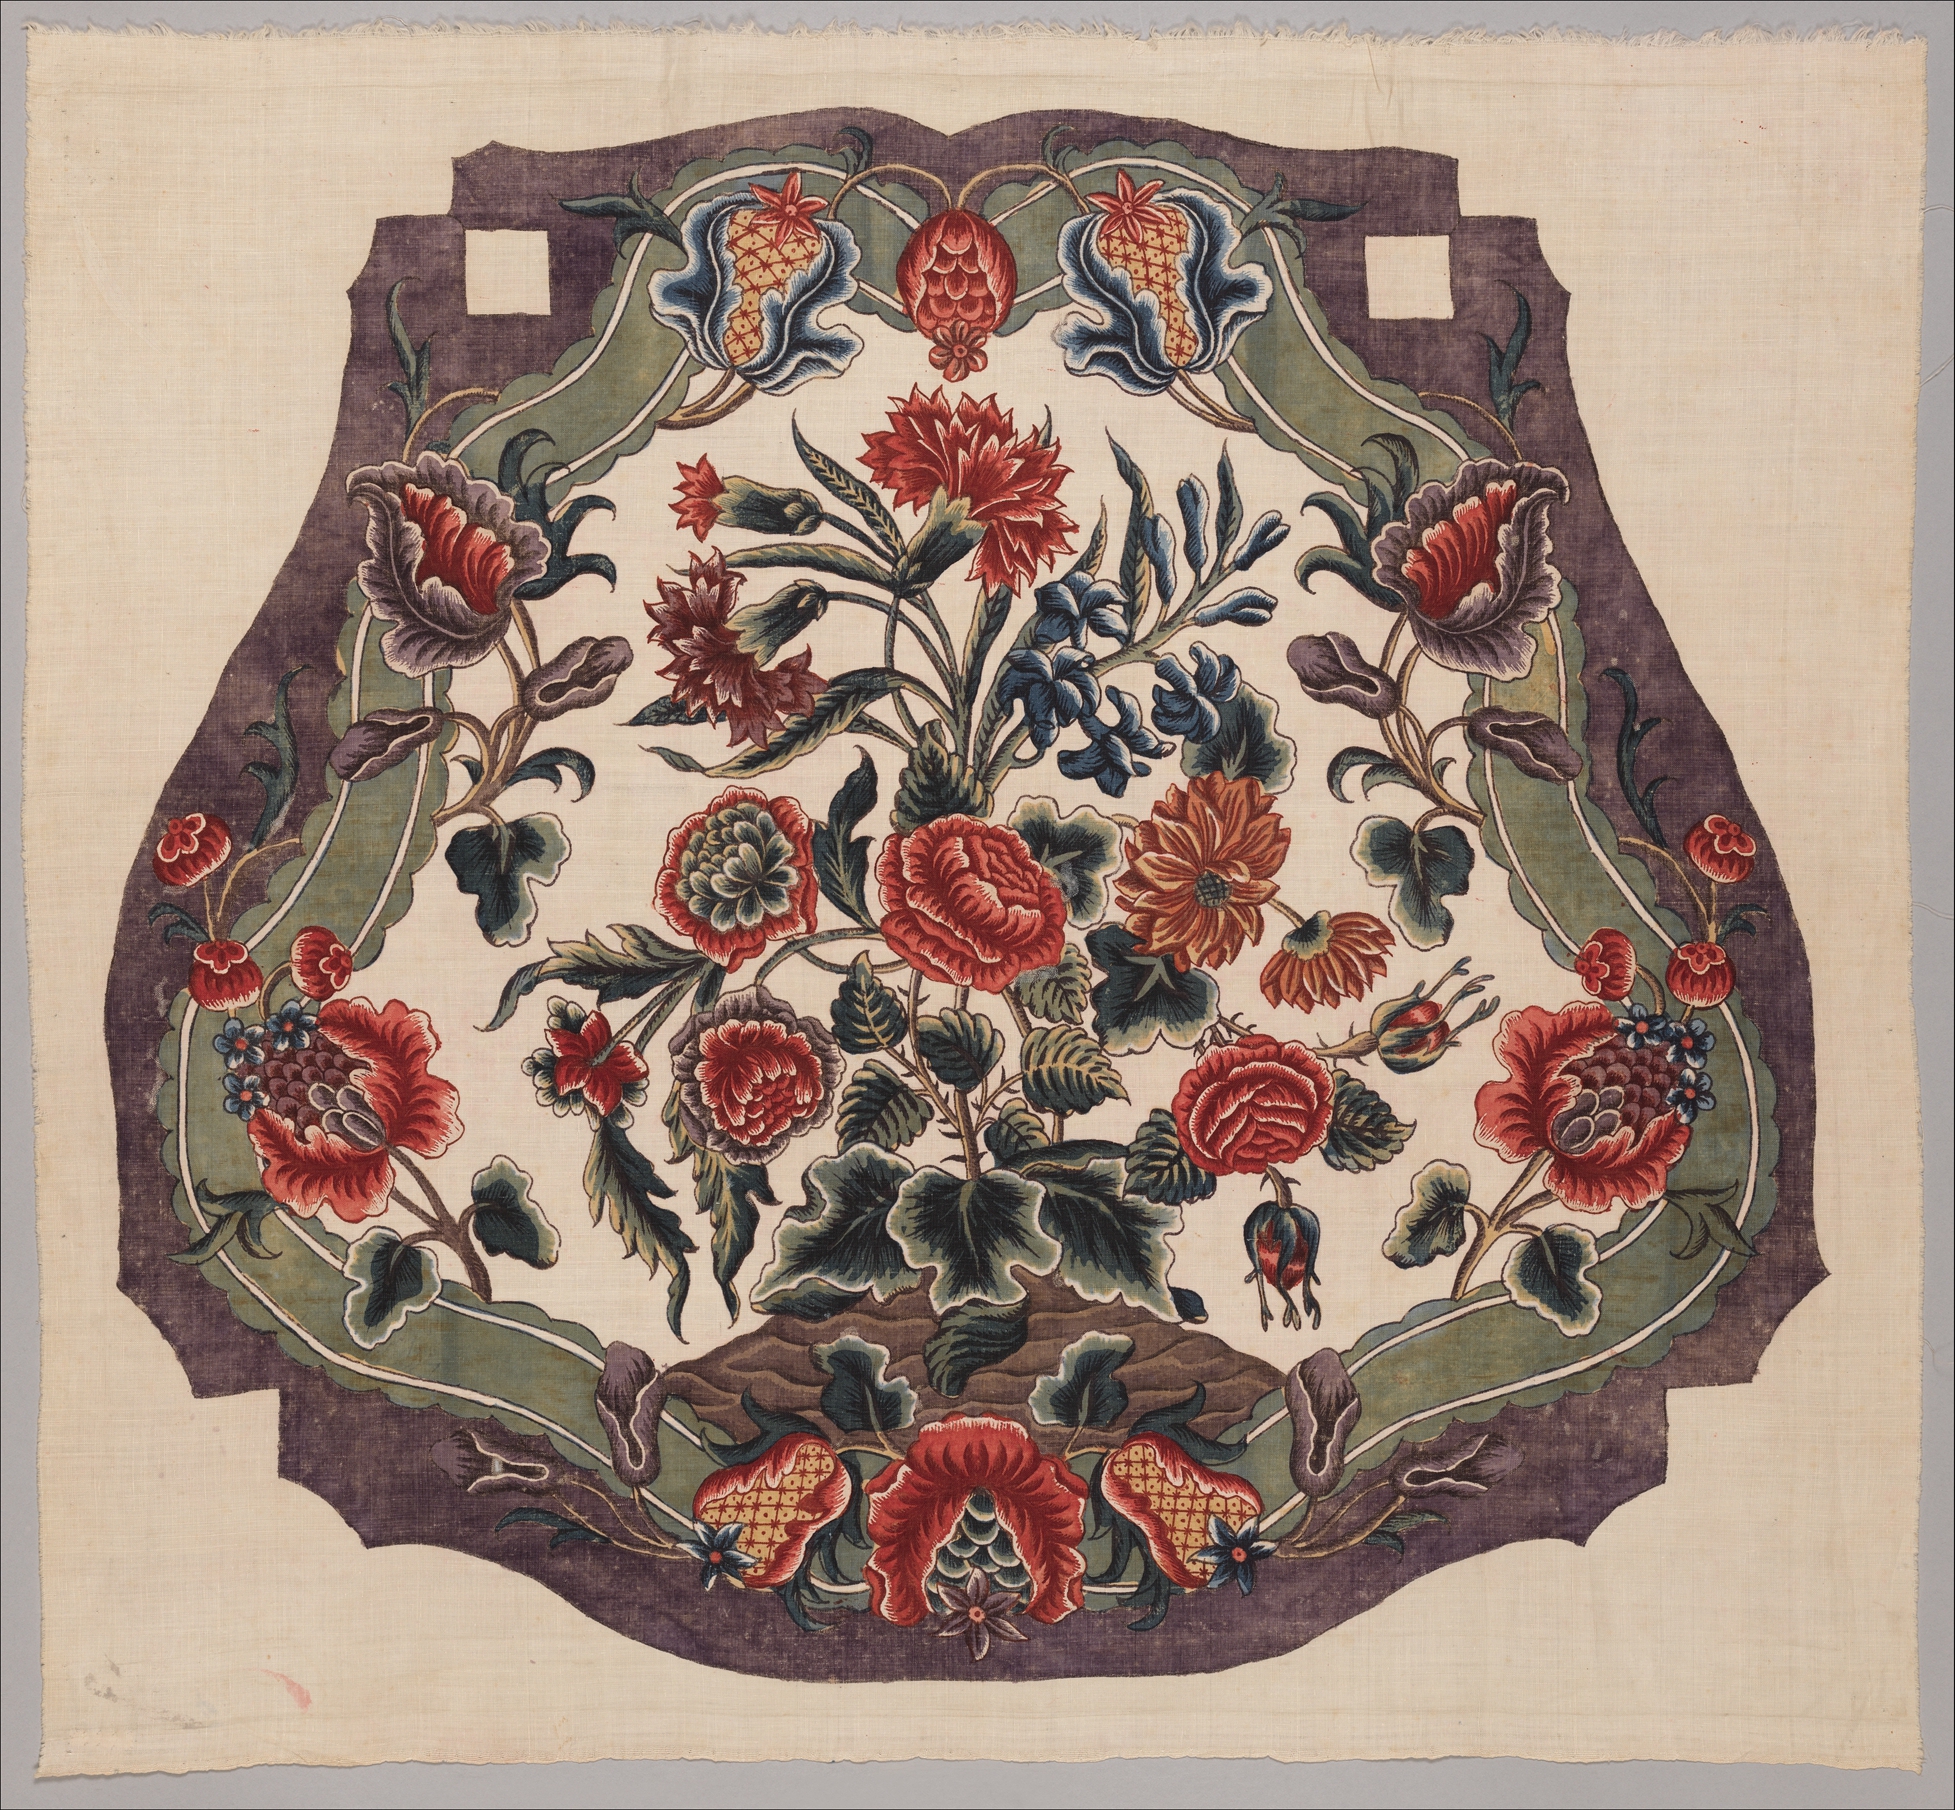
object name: upholstery panel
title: Chair seat cover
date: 1725-1750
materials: cotton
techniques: dyeing, painting, resist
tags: flowers,roses